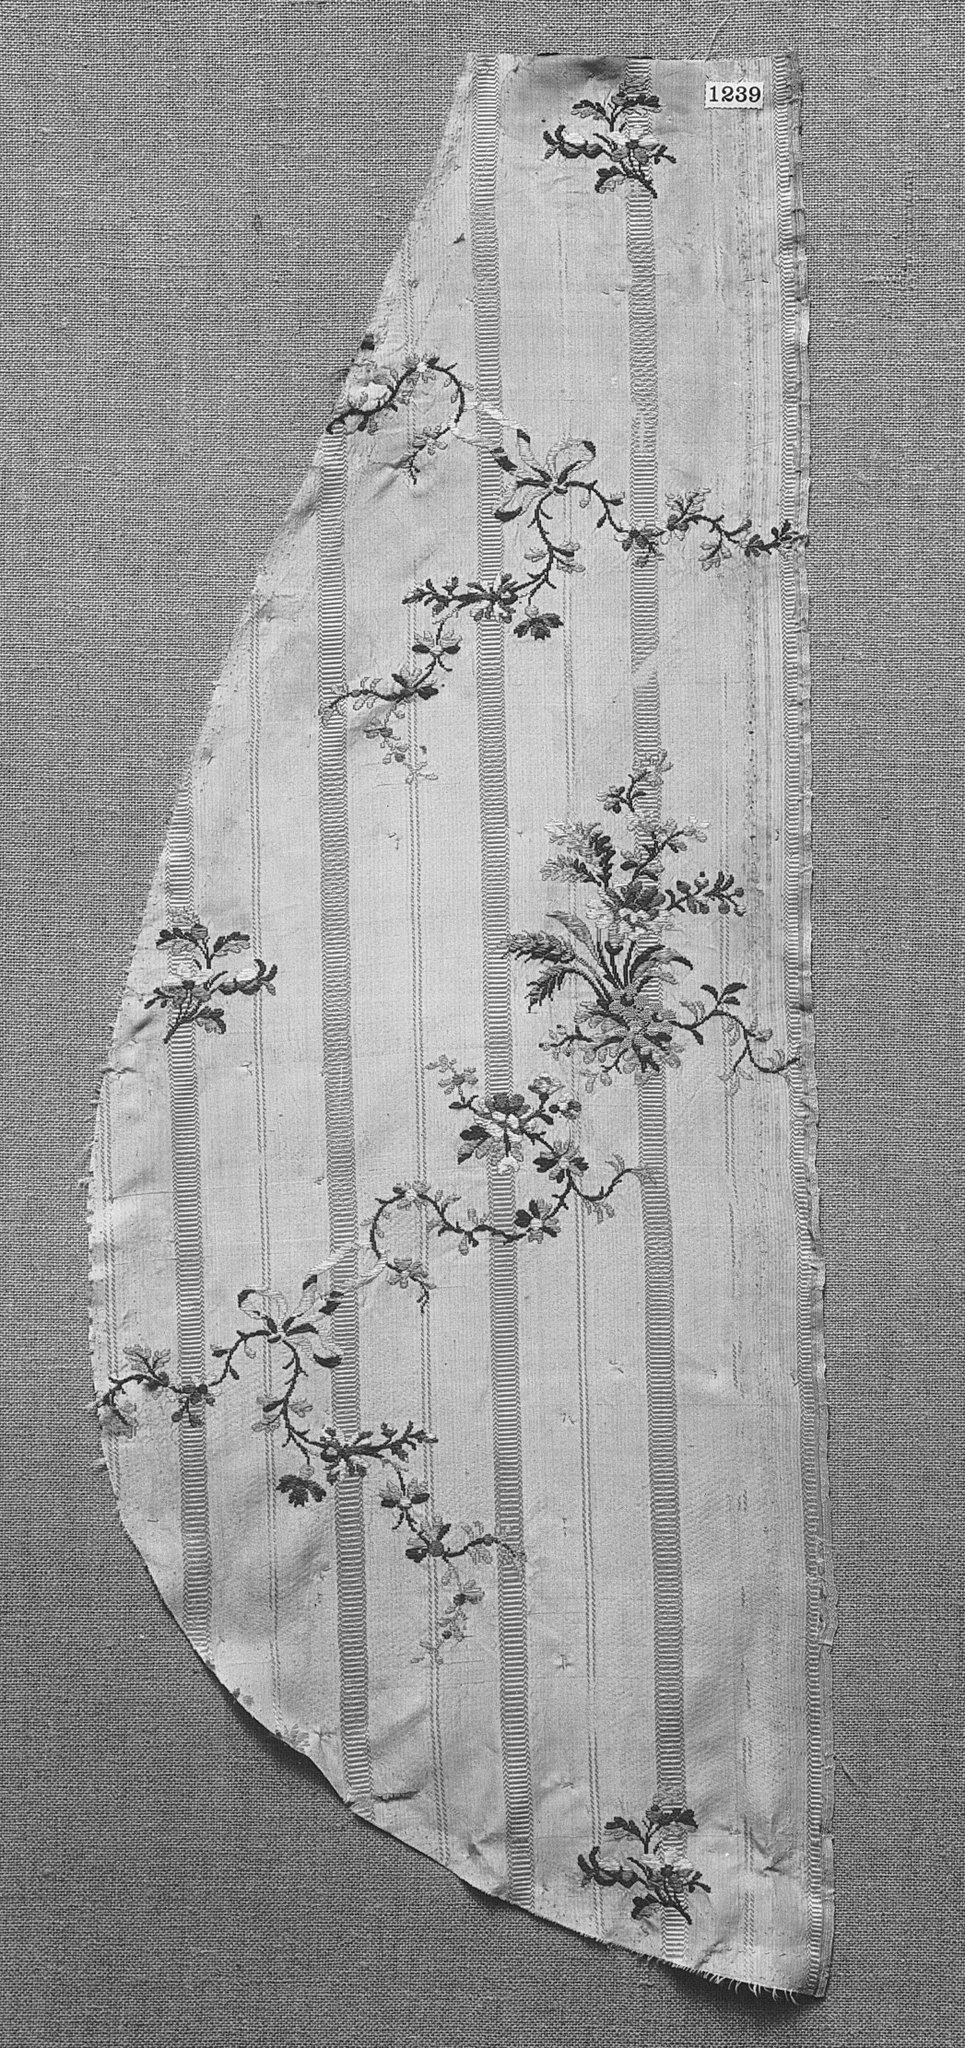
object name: piece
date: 1767-1800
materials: silk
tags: leaves